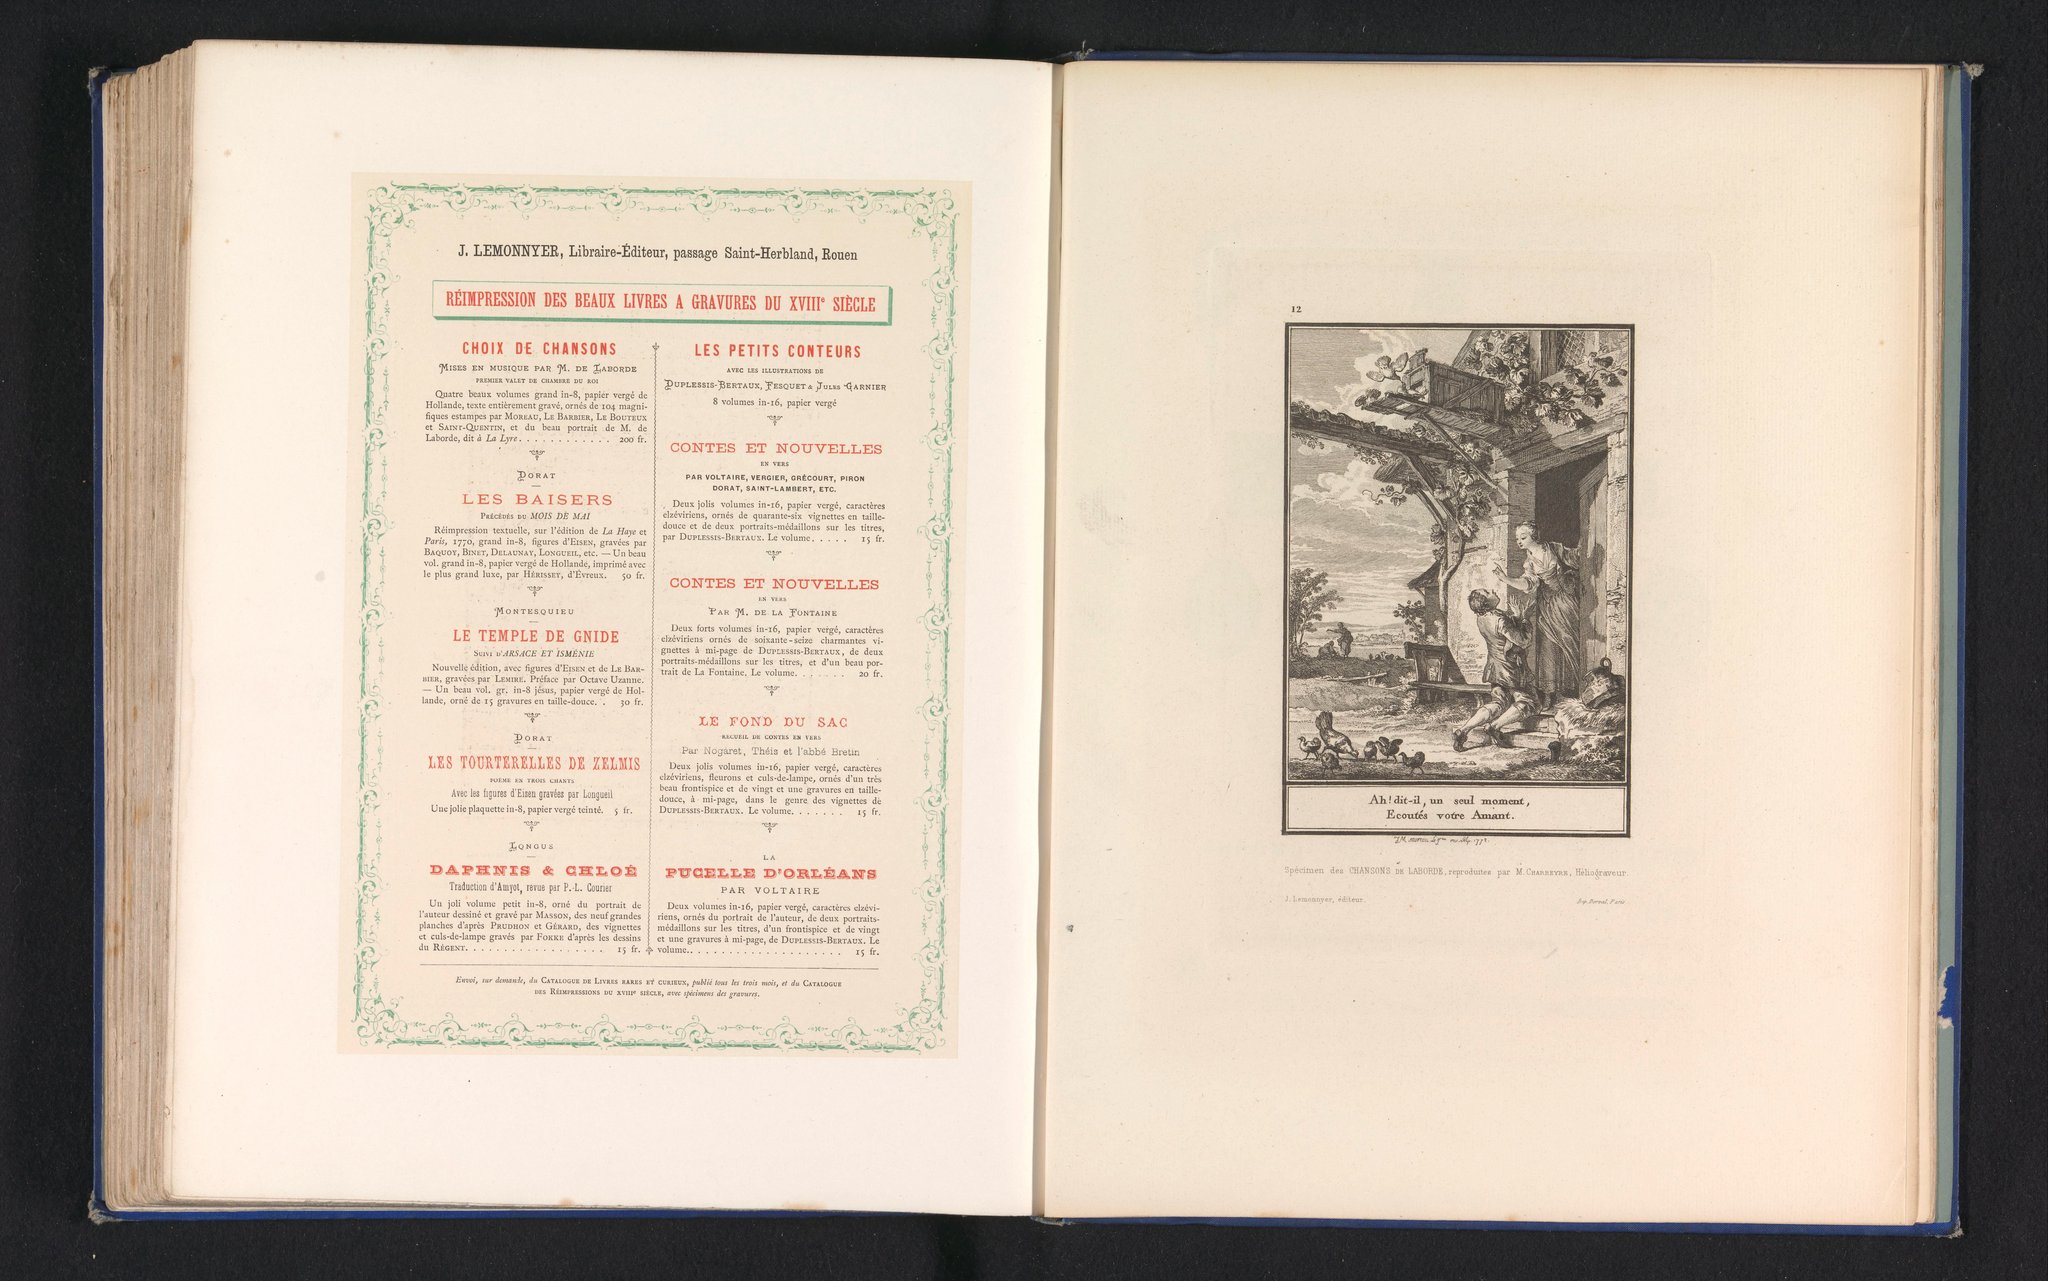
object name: page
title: Fotoreproductie van een prent, voorstellende een man op zijn knieën voor het huis van een vrouw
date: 1871-1881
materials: paper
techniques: photoaquatint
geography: france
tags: façade (of house or building), lovers; courting, flirting, kneeling on both knees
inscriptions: inscription: ‘Ah! dit-il, un seul moment, Ecoutés votre Amant.’, number: ‘12’